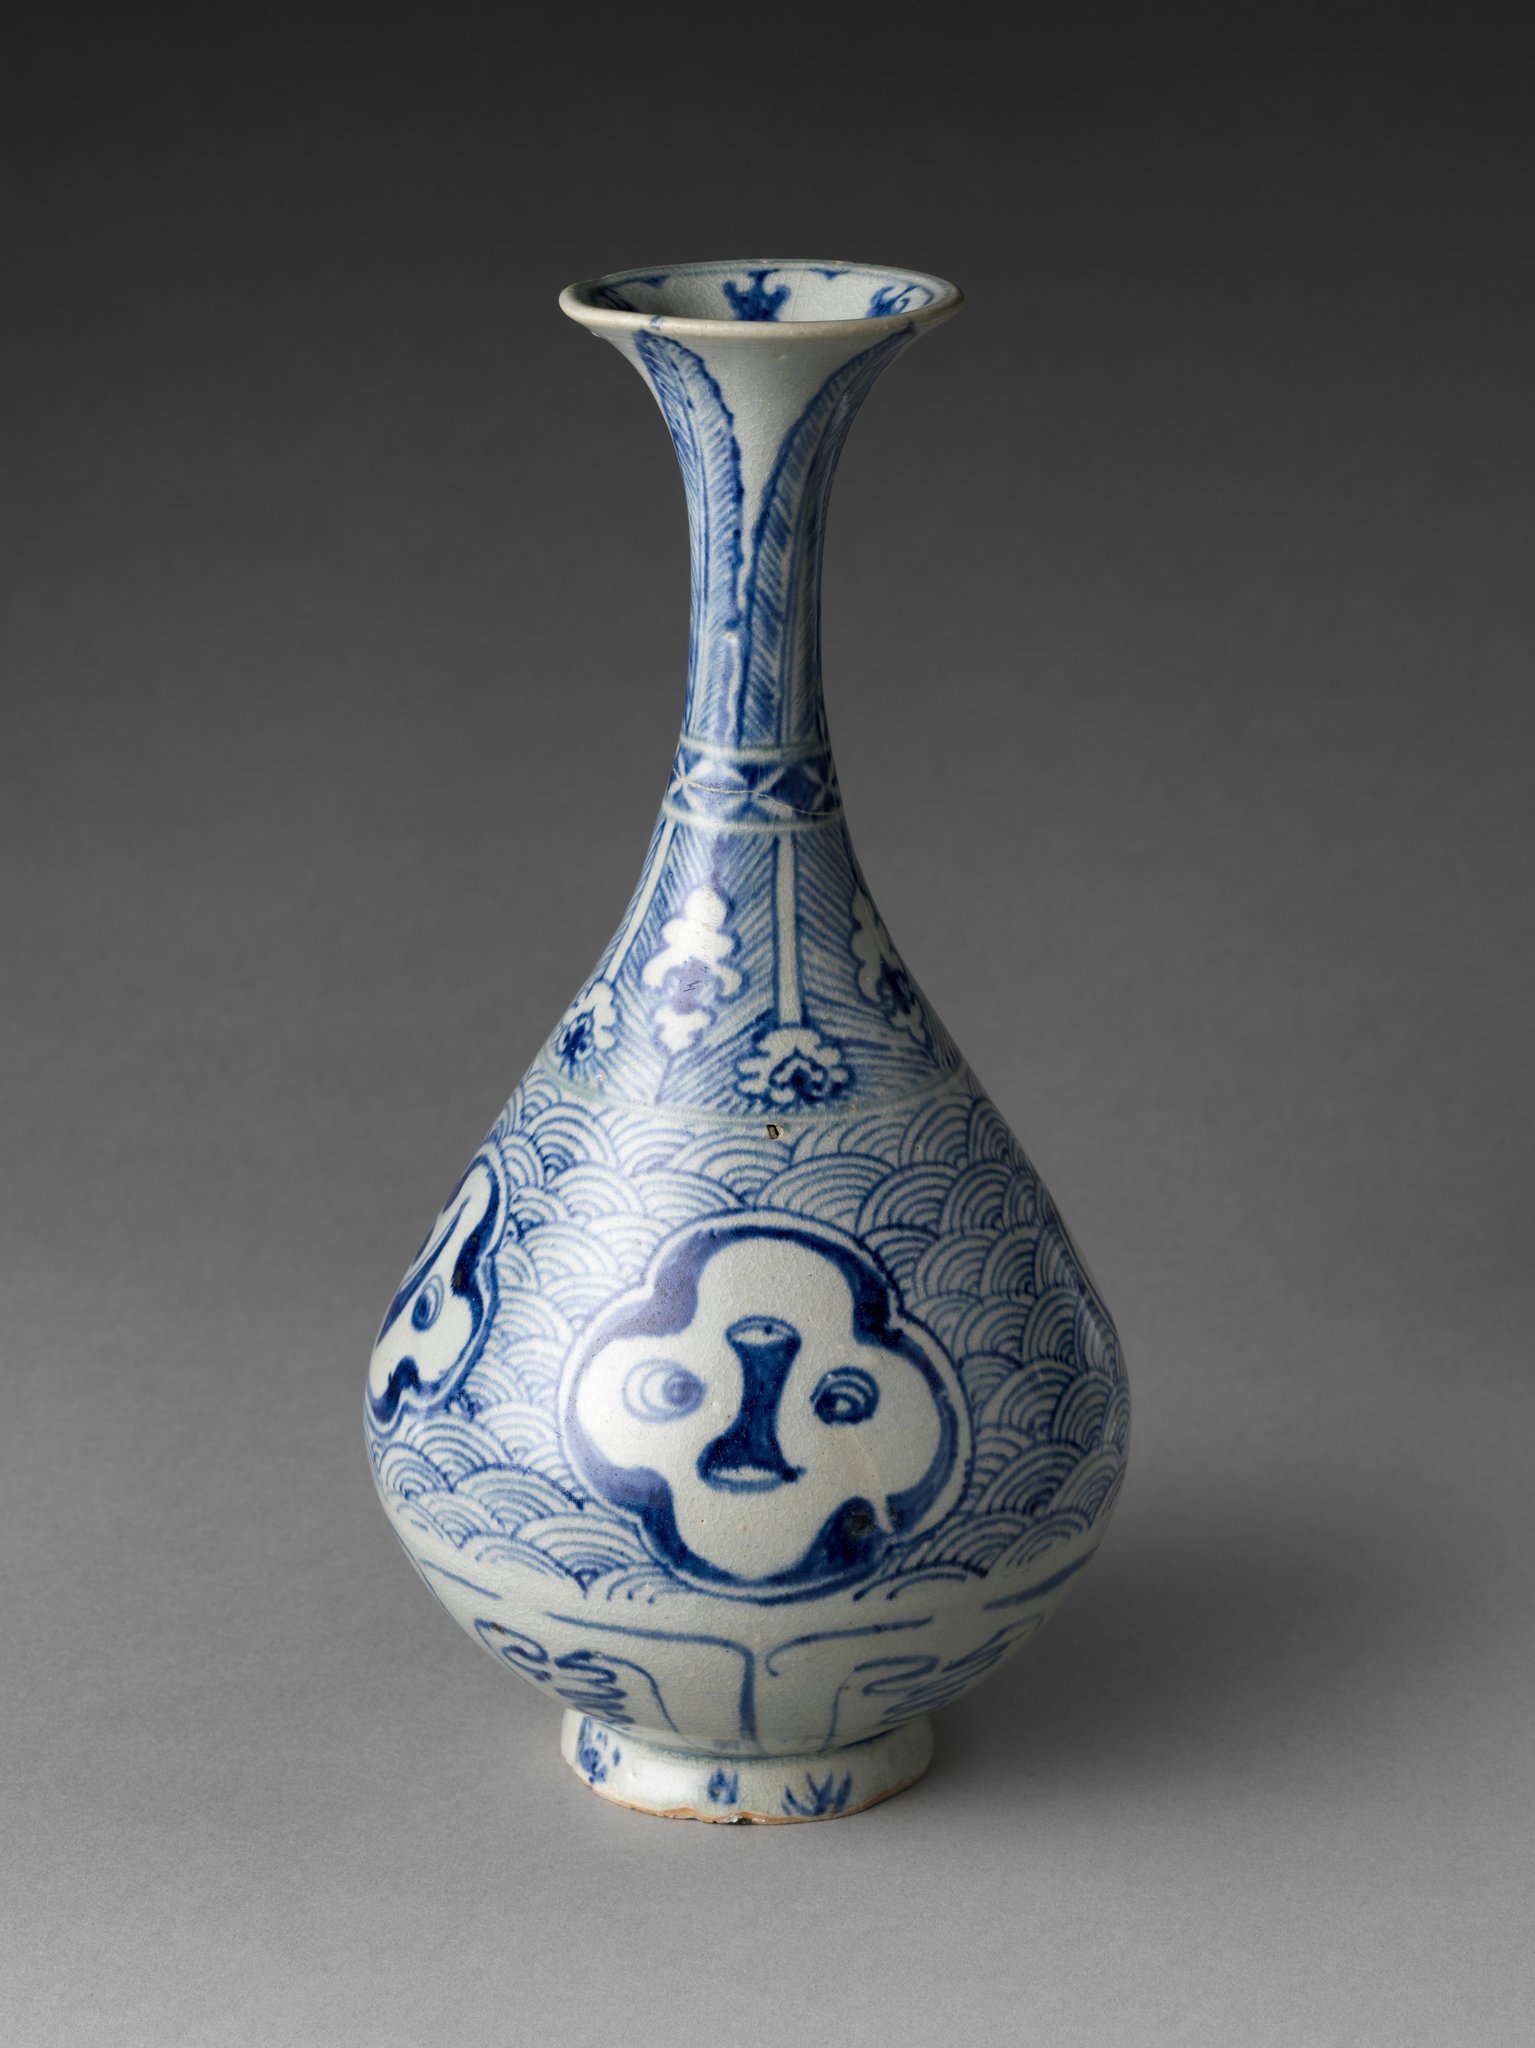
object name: bottle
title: Bottle with Waves and Auspicious Emblems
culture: vietnamese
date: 1301-1400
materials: cobalt, glaze, stoneware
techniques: painting